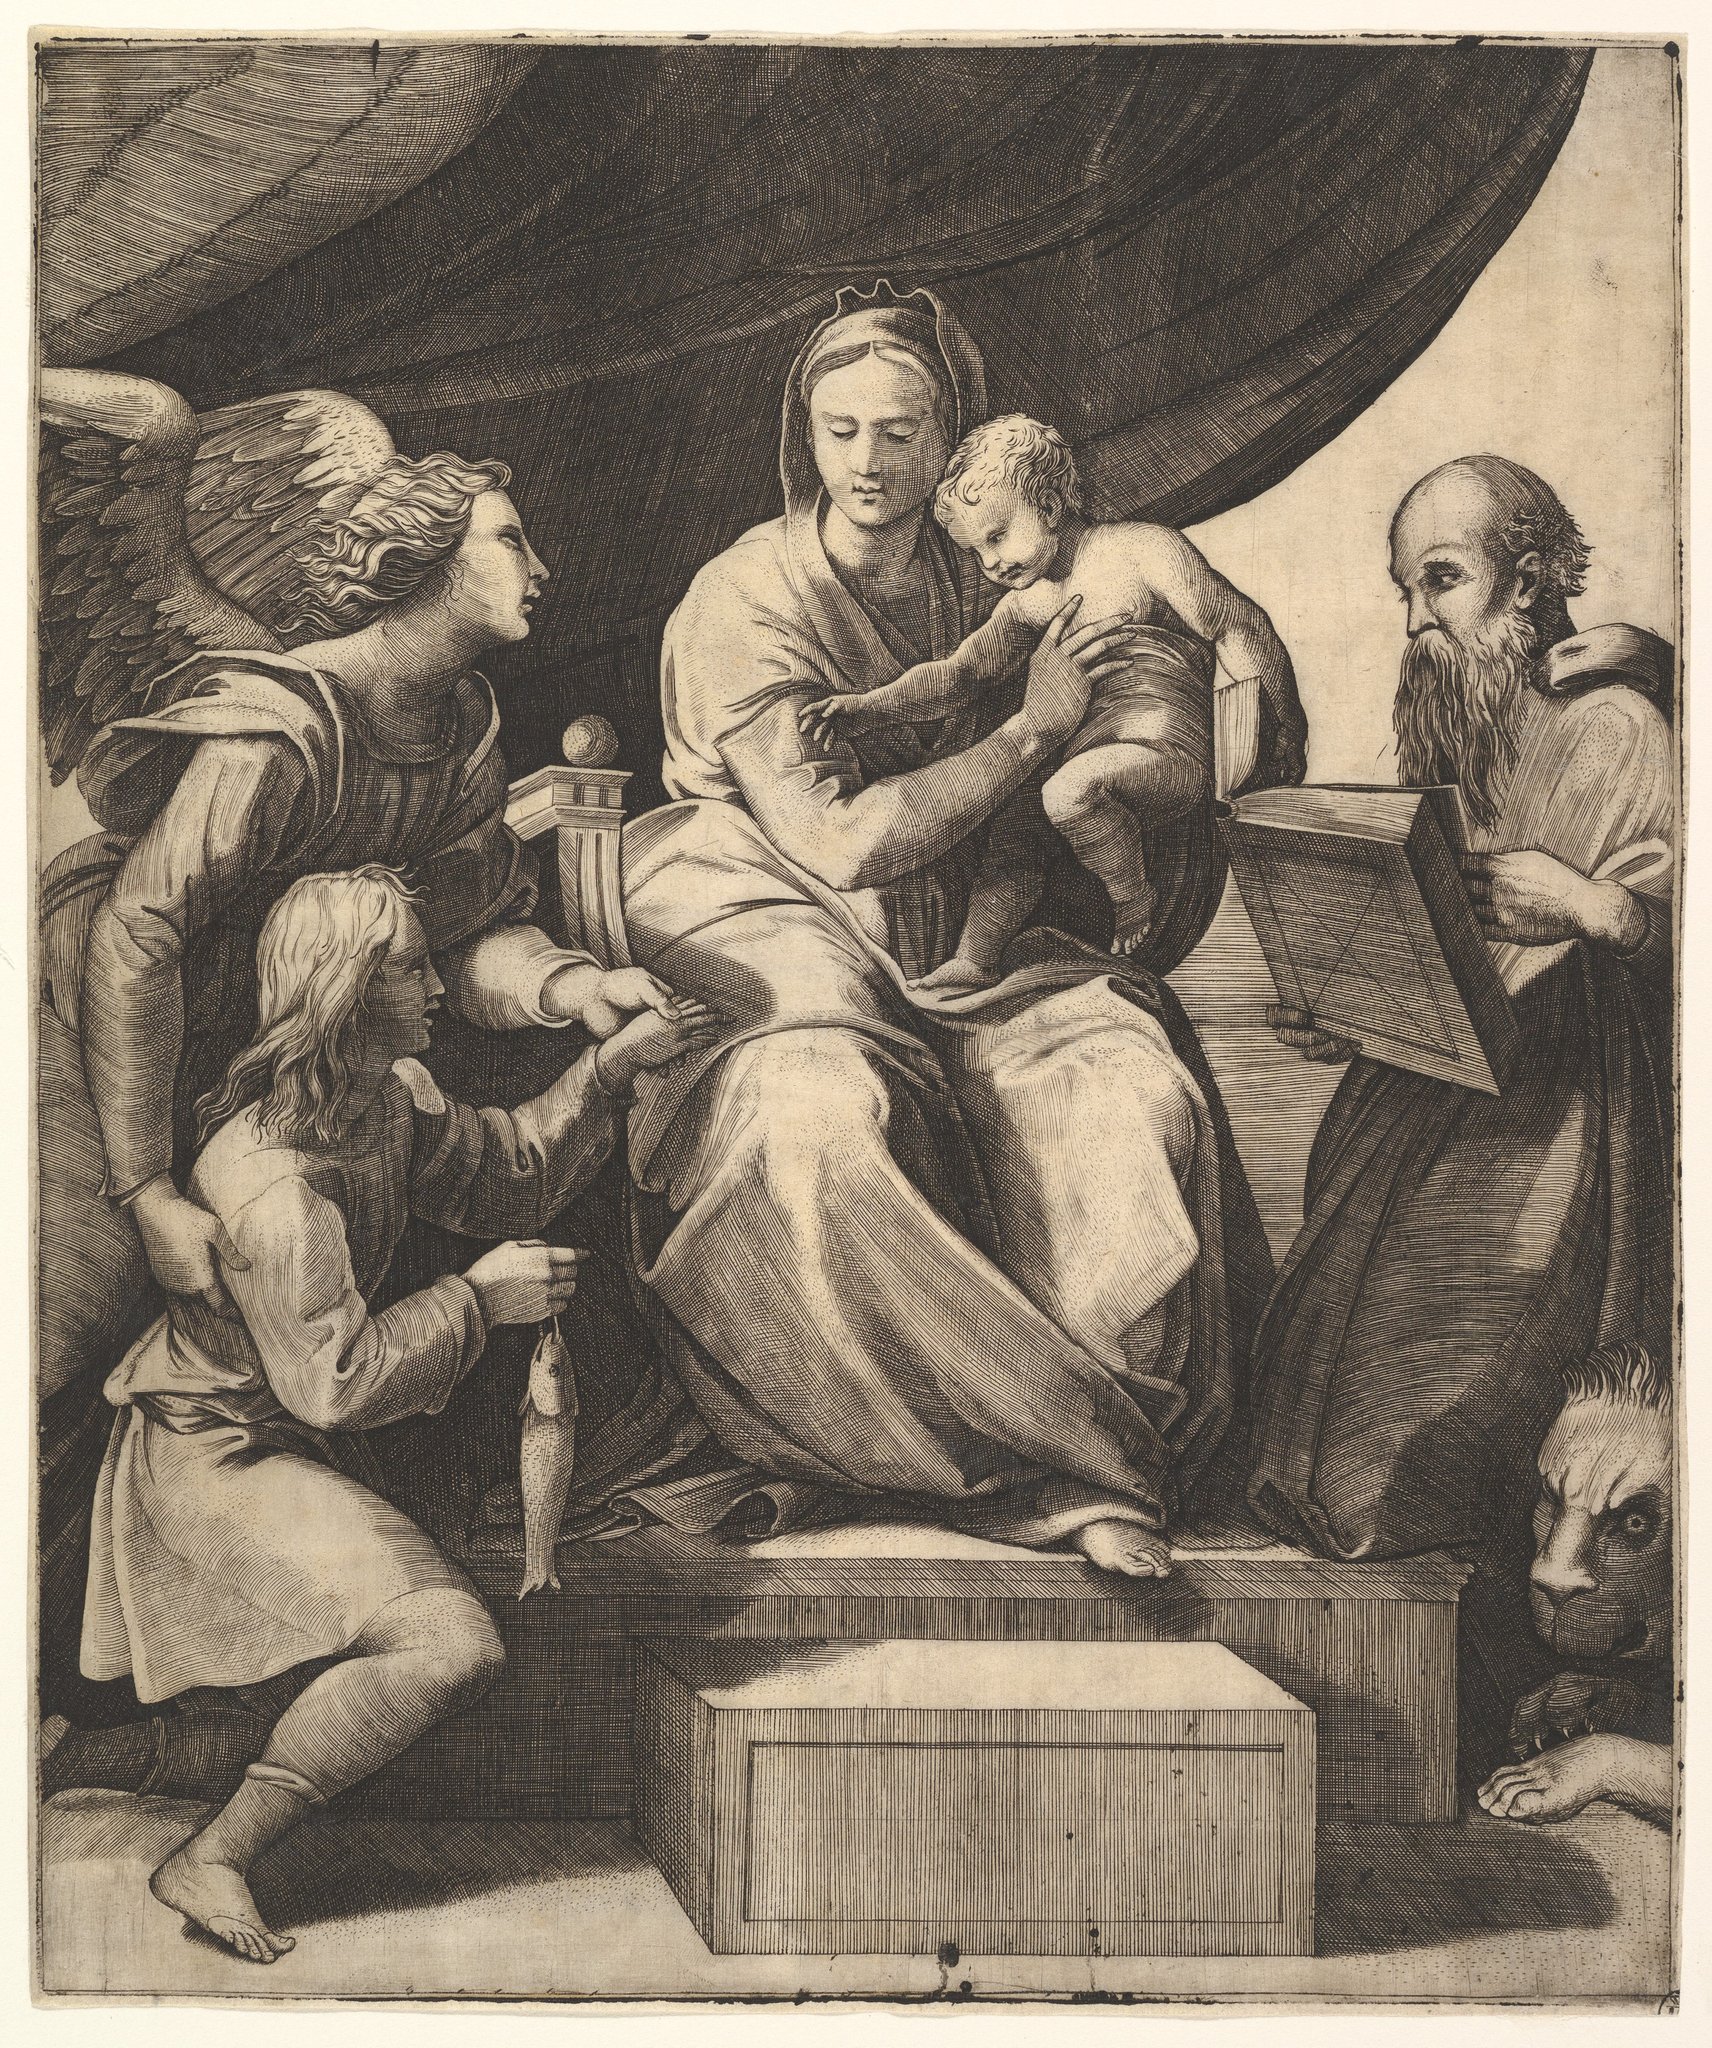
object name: print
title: The Madonna with the Fish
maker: marcantonio raimondi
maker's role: artist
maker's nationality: italian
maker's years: 1475-1534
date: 1515-1527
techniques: engraving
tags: girls,fish,angels,virgin mary